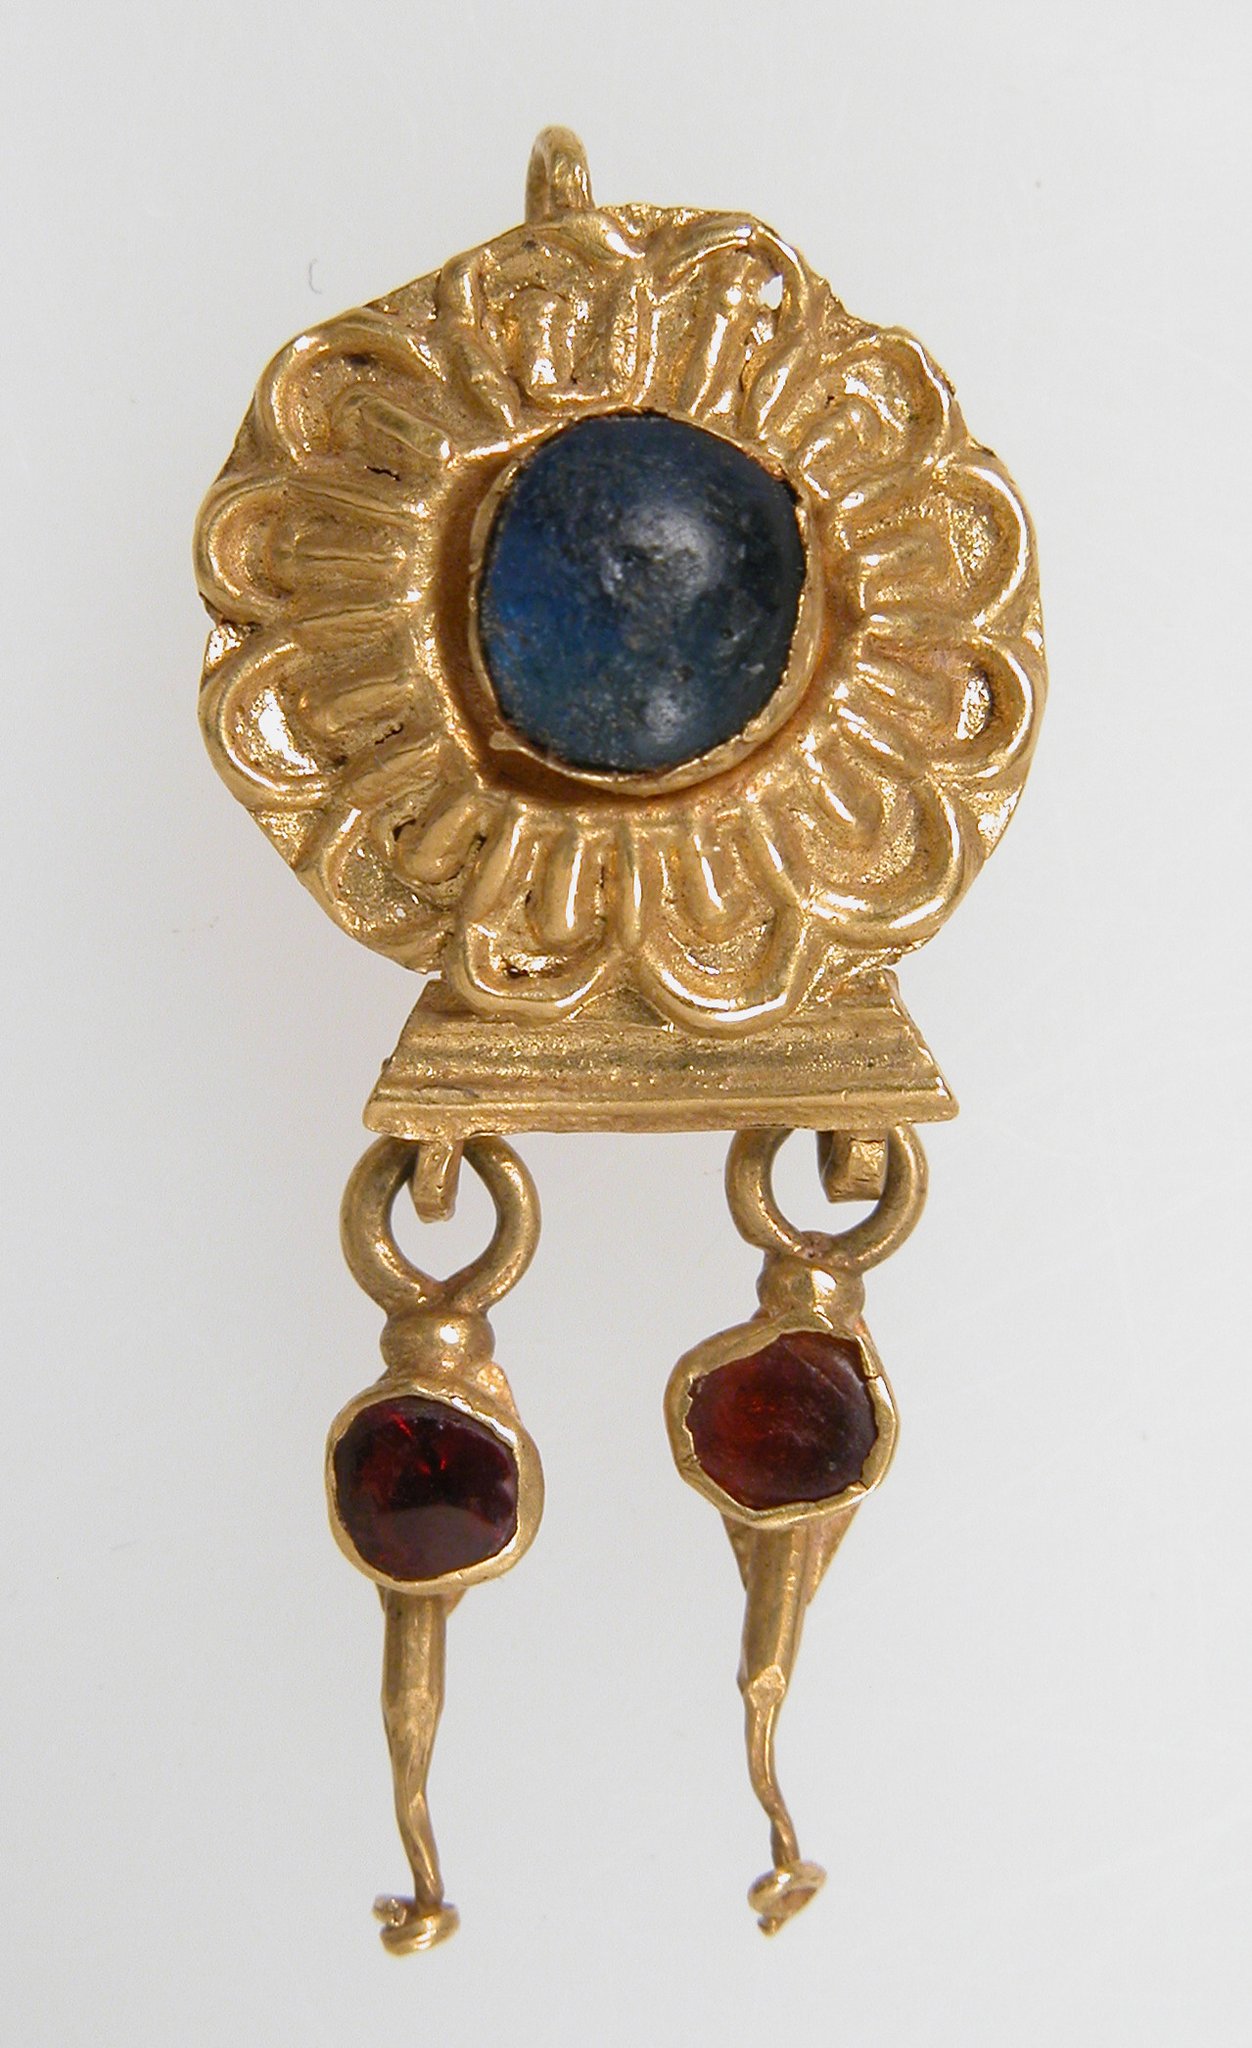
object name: earring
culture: pontic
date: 201-300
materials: gemstone, glass, gold, paste